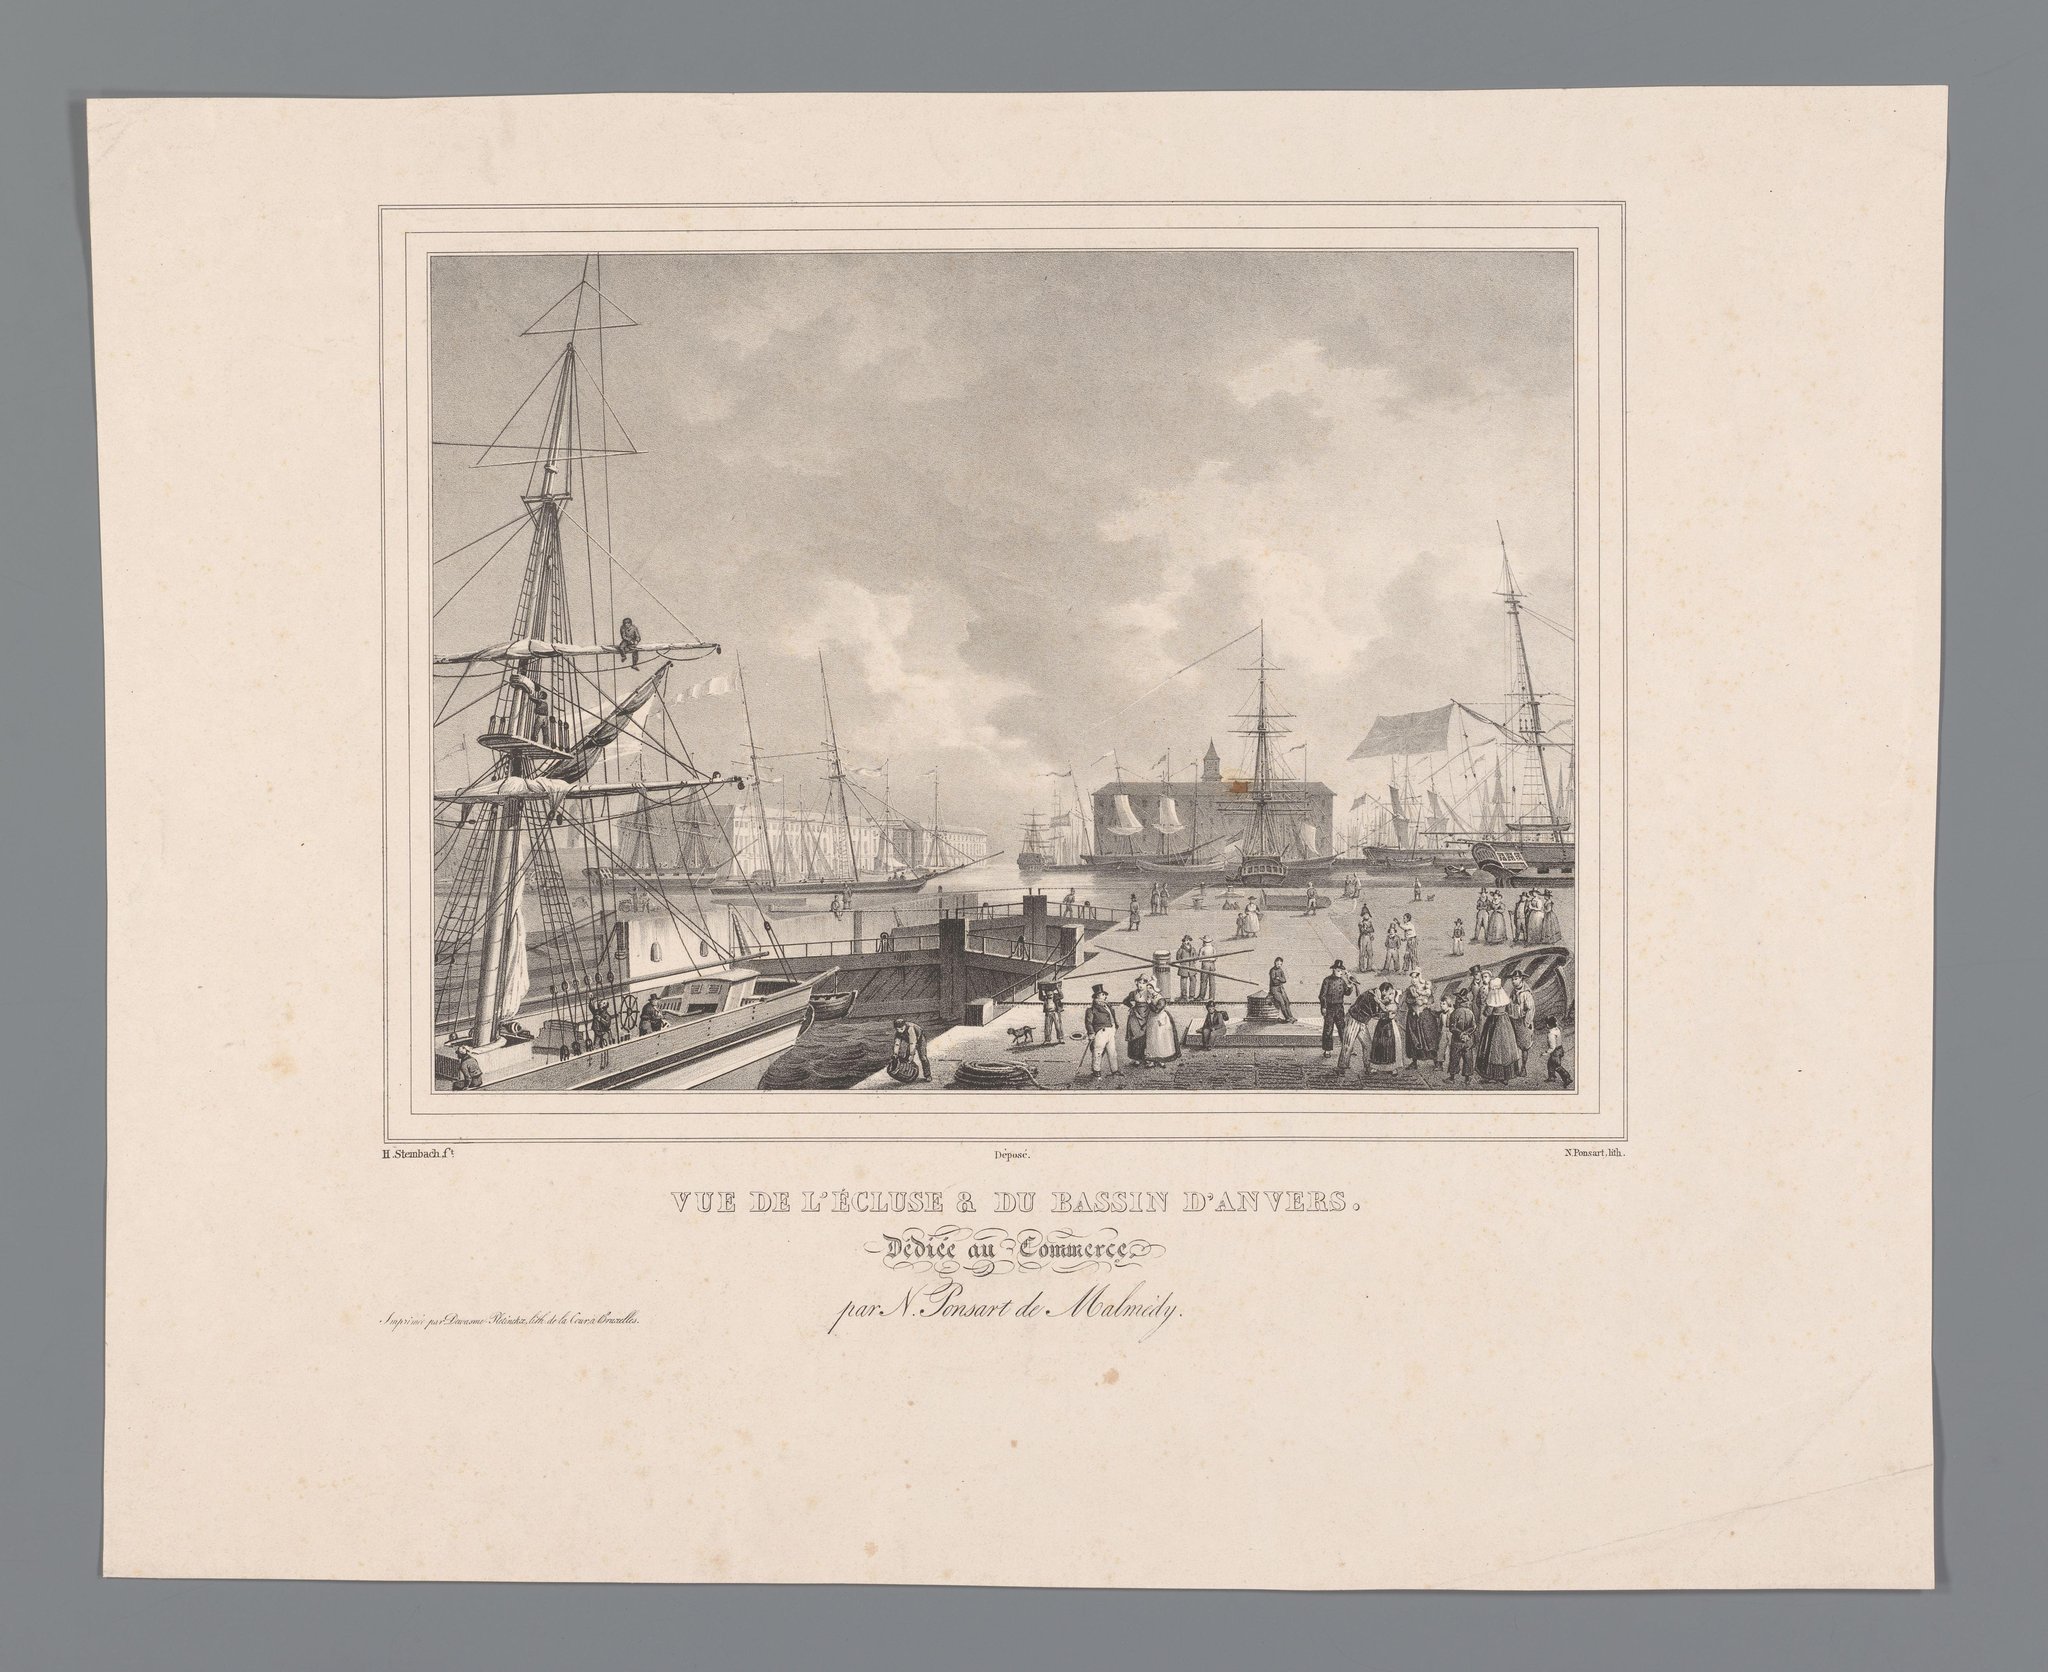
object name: print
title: Vue de l'Écluse & du bassin d'Anvers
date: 1800-1850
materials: paper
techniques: lithograph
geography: malmedy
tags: harbour, pier, quay, wharf, antwerp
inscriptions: : ‘Déposé’